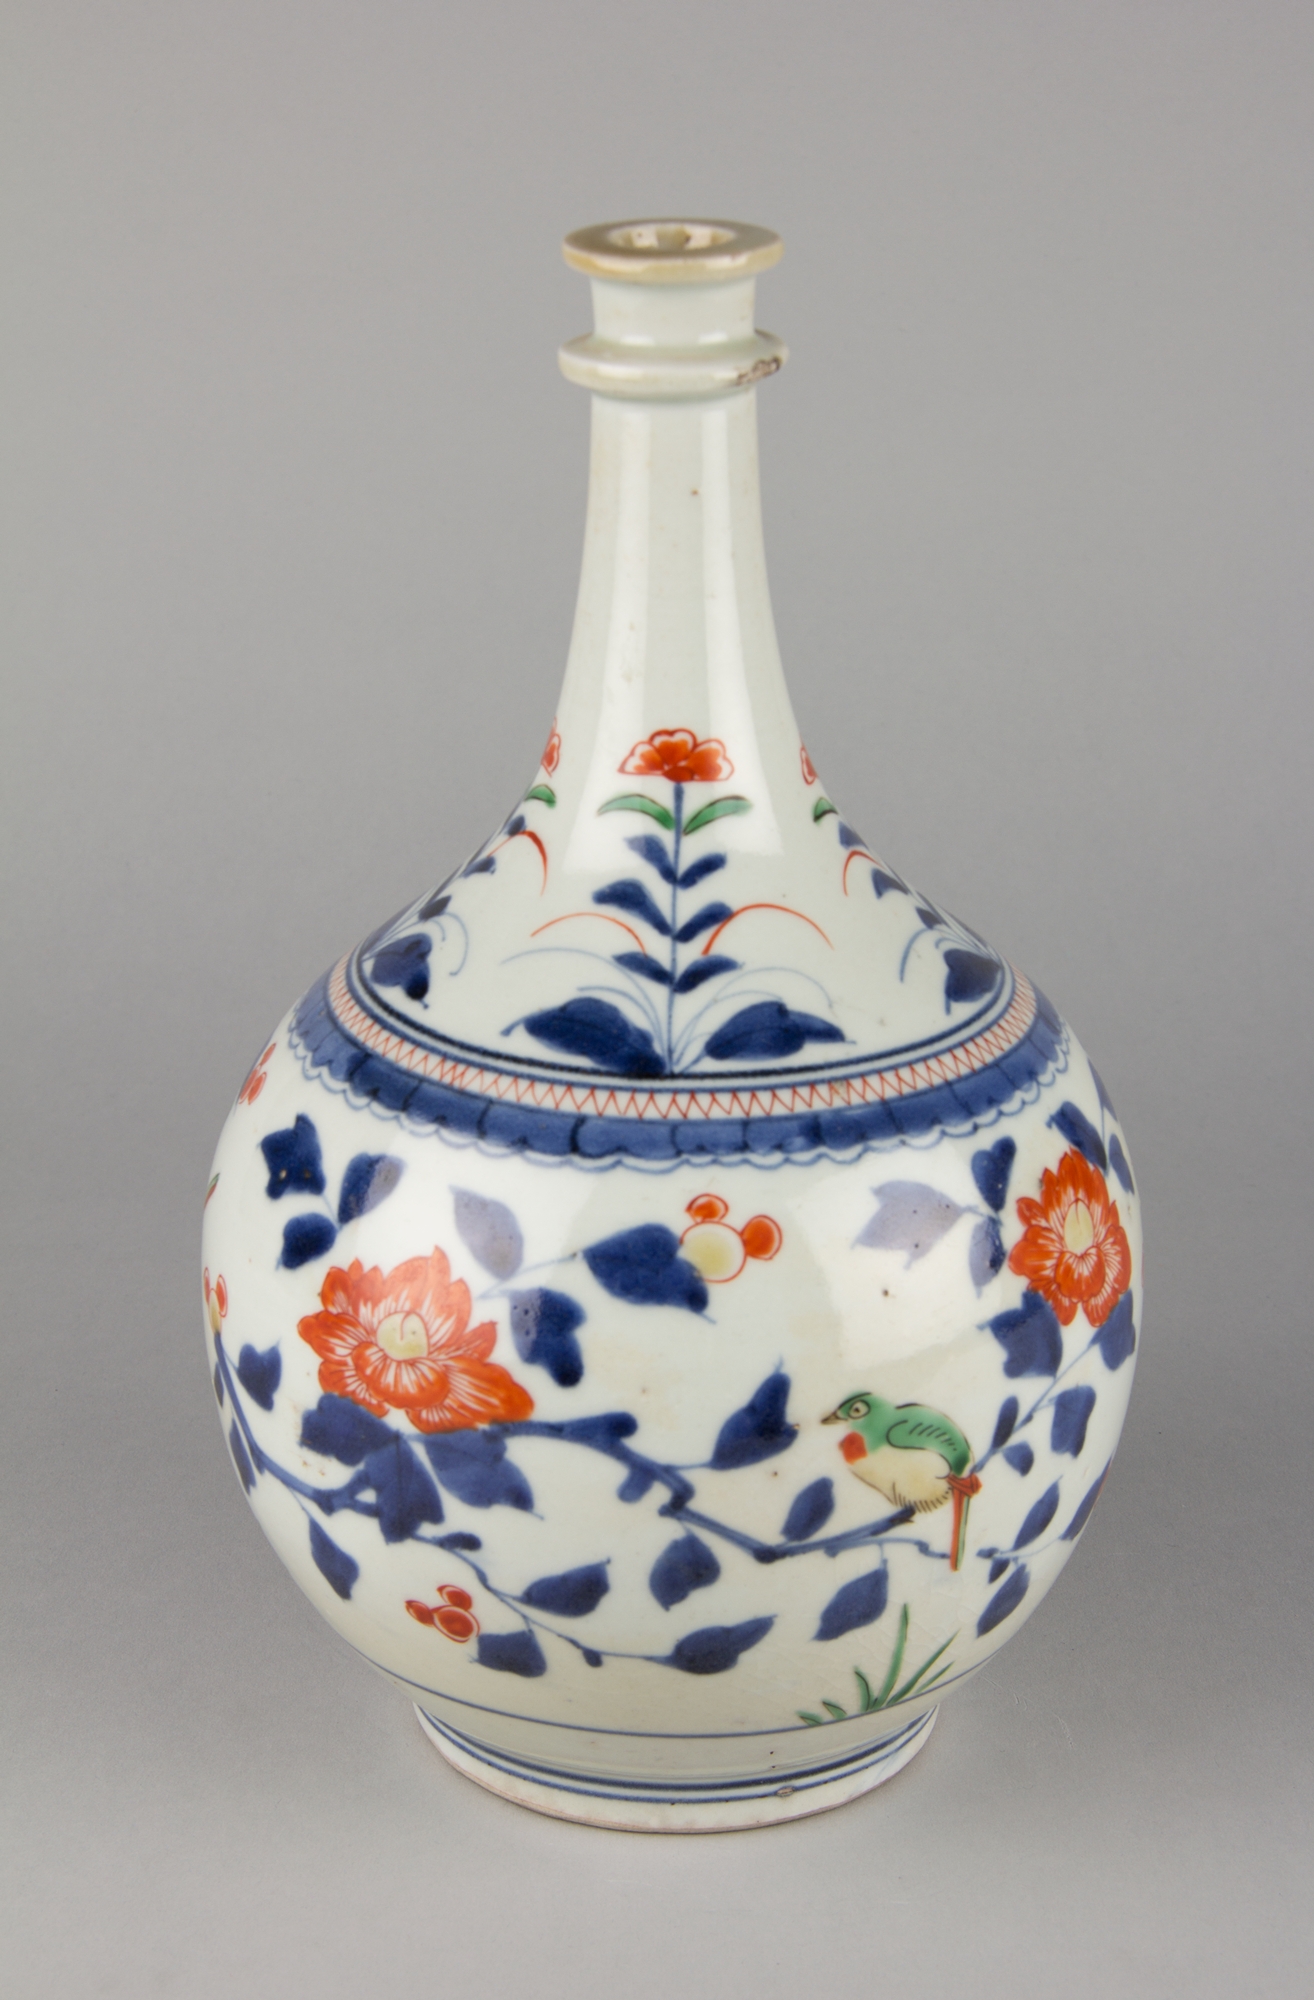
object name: apothecary bottle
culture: japanese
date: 1651-1700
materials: enamel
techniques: overglaze, underglaze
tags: birds,flowers,leaves